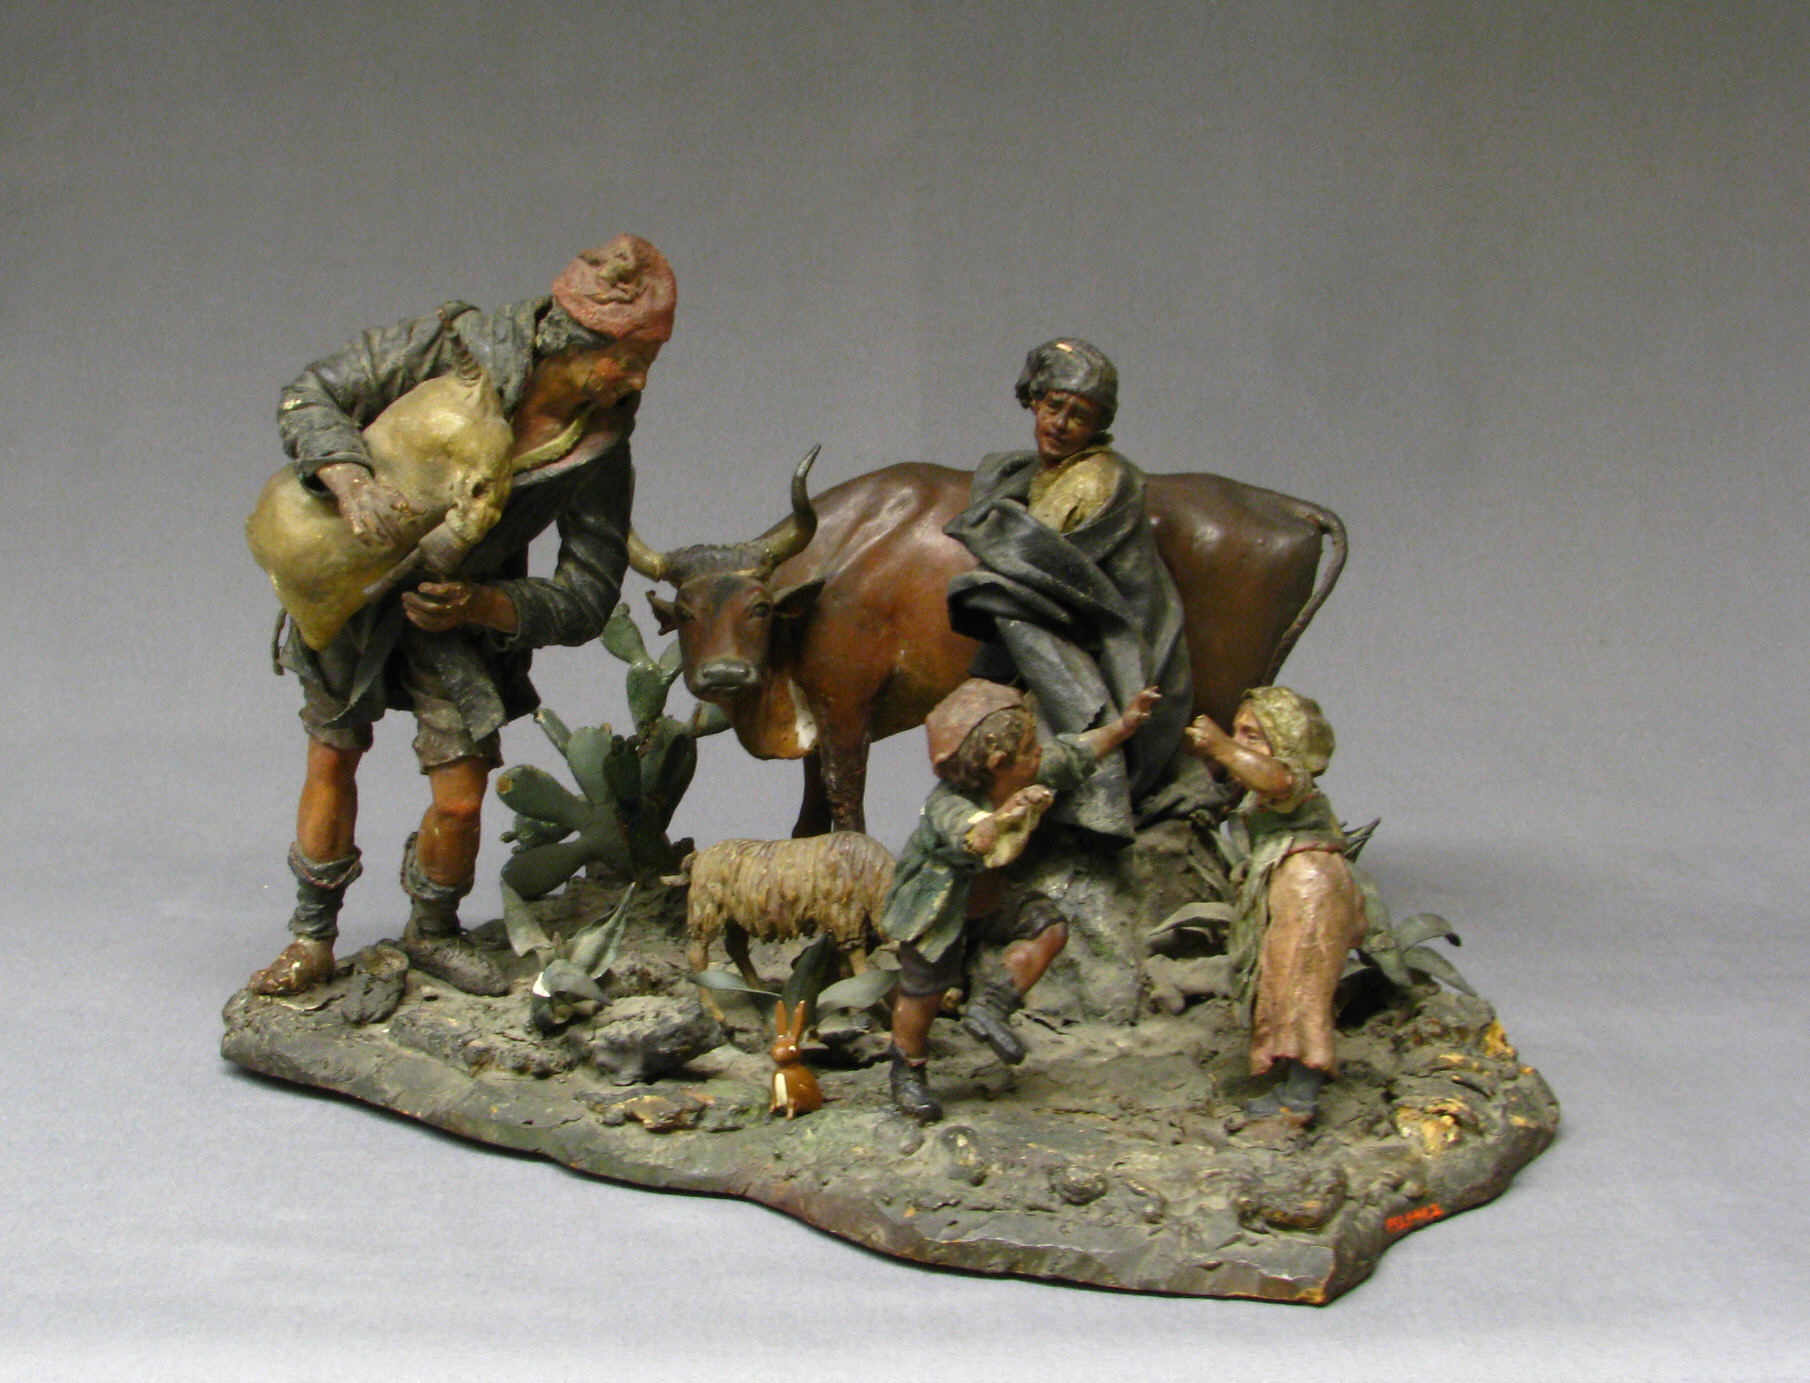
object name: crèche figure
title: Group of rustic figures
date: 1701-1800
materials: textile, gesso, wood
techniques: polychrome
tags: children,men,bagpipes,bulls,sheep,plants